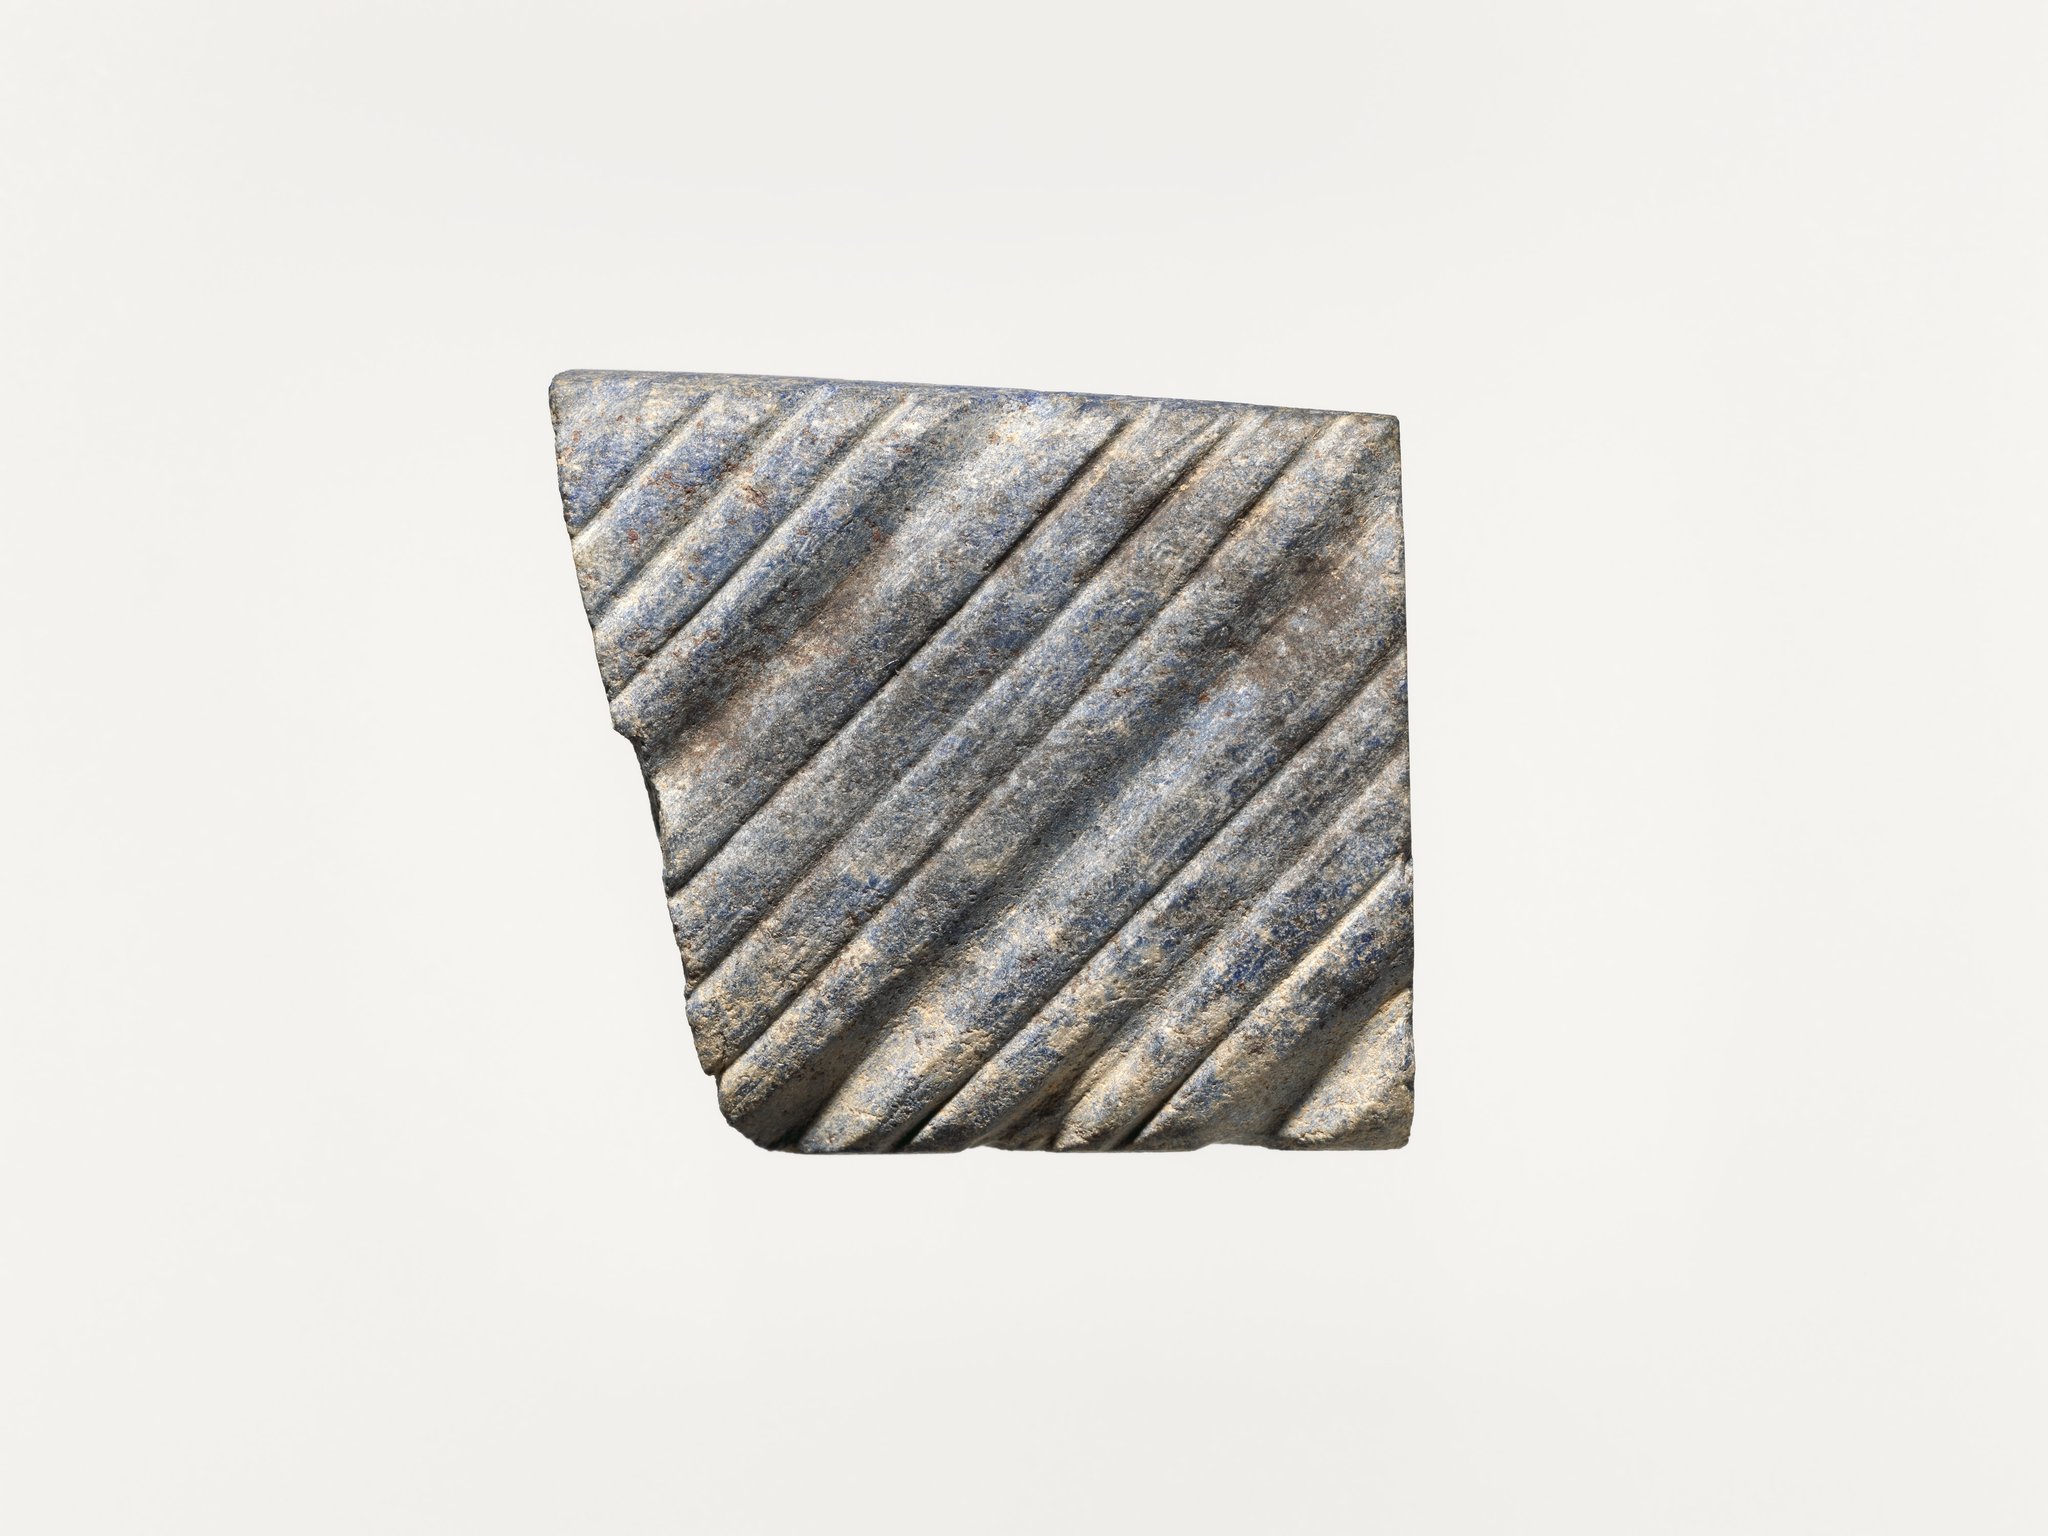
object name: inlay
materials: lapis lazuli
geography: mesopotamia